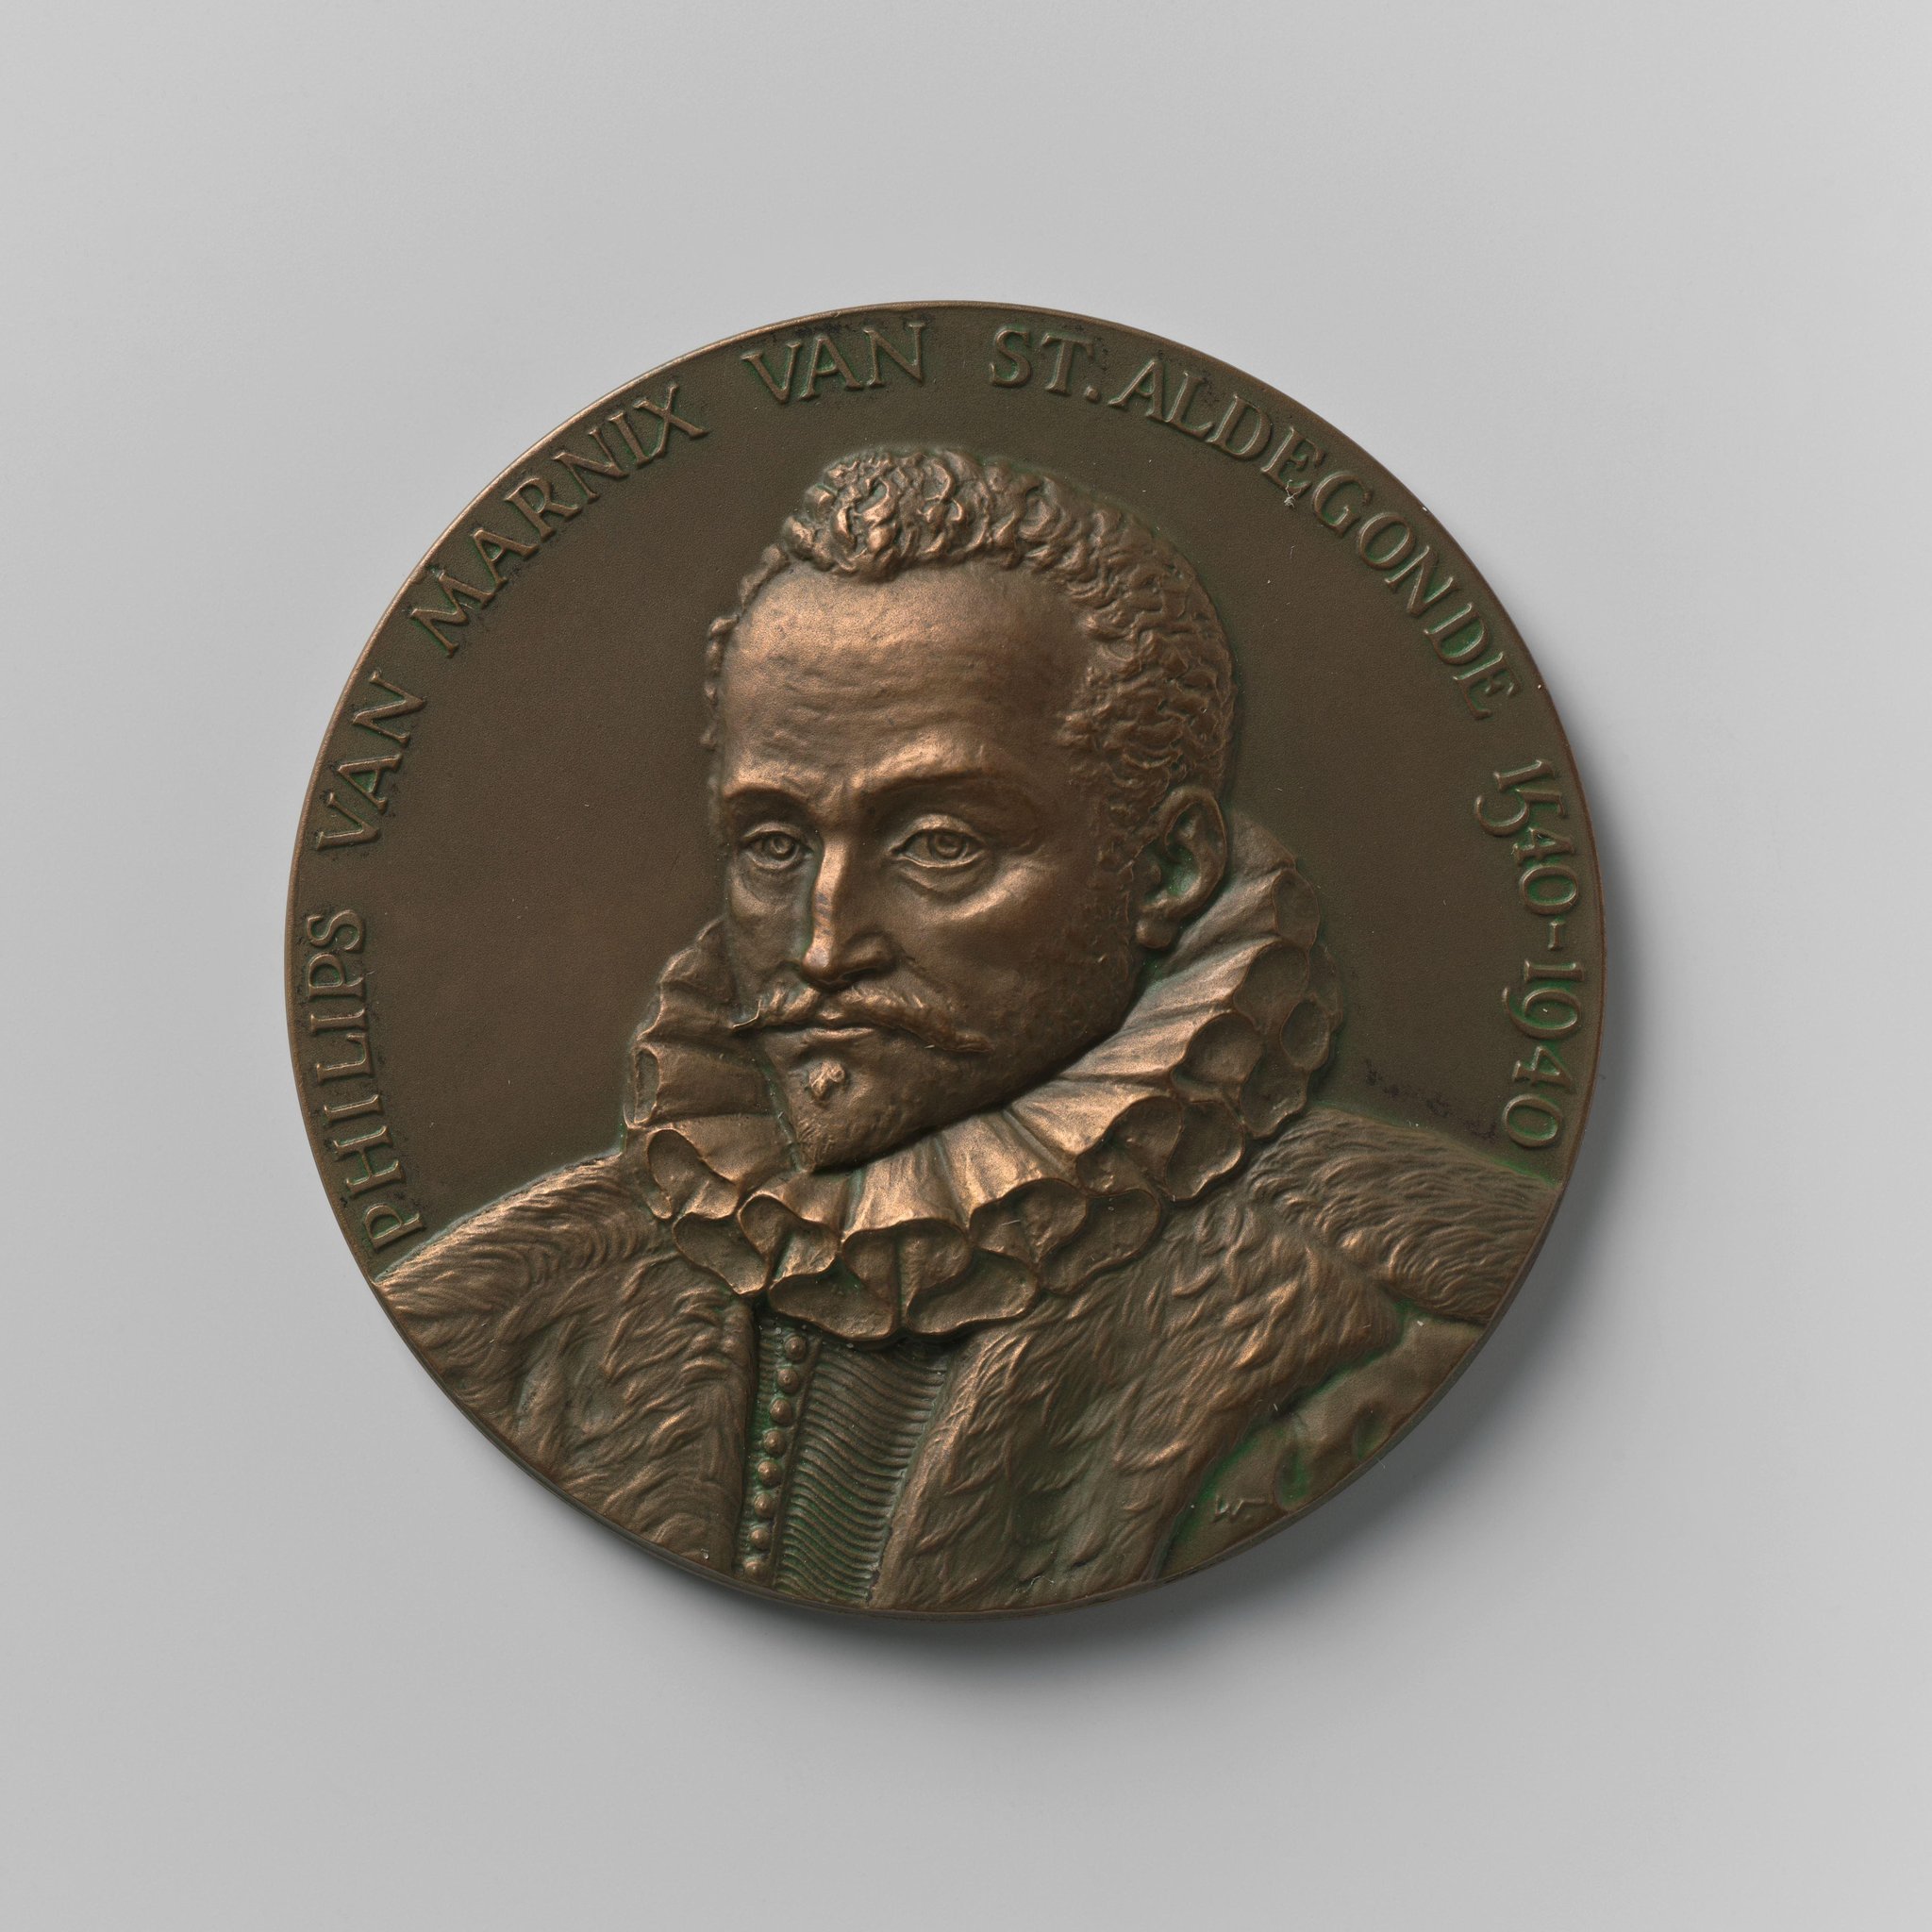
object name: history medal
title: Vierhonderdste geboortejaar Philips van Marnix van Sint Aldegonde (Vereniging voor Penningkunst 1940, eerste penning)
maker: han wezelaar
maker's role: draughtsman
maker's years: 1901-1984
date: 1940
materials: bronze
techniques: striking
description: Bronzen penning, op de voorzijde het borstbeeld van Van Sint Aldegonde half naar links met omschrift, op de keerzijde een zeilschip op zee onder de stralende naam Gods, met in het verschiet winden en rotsen en onderaan een zeemonster op een tekstvaan, met verklaring.